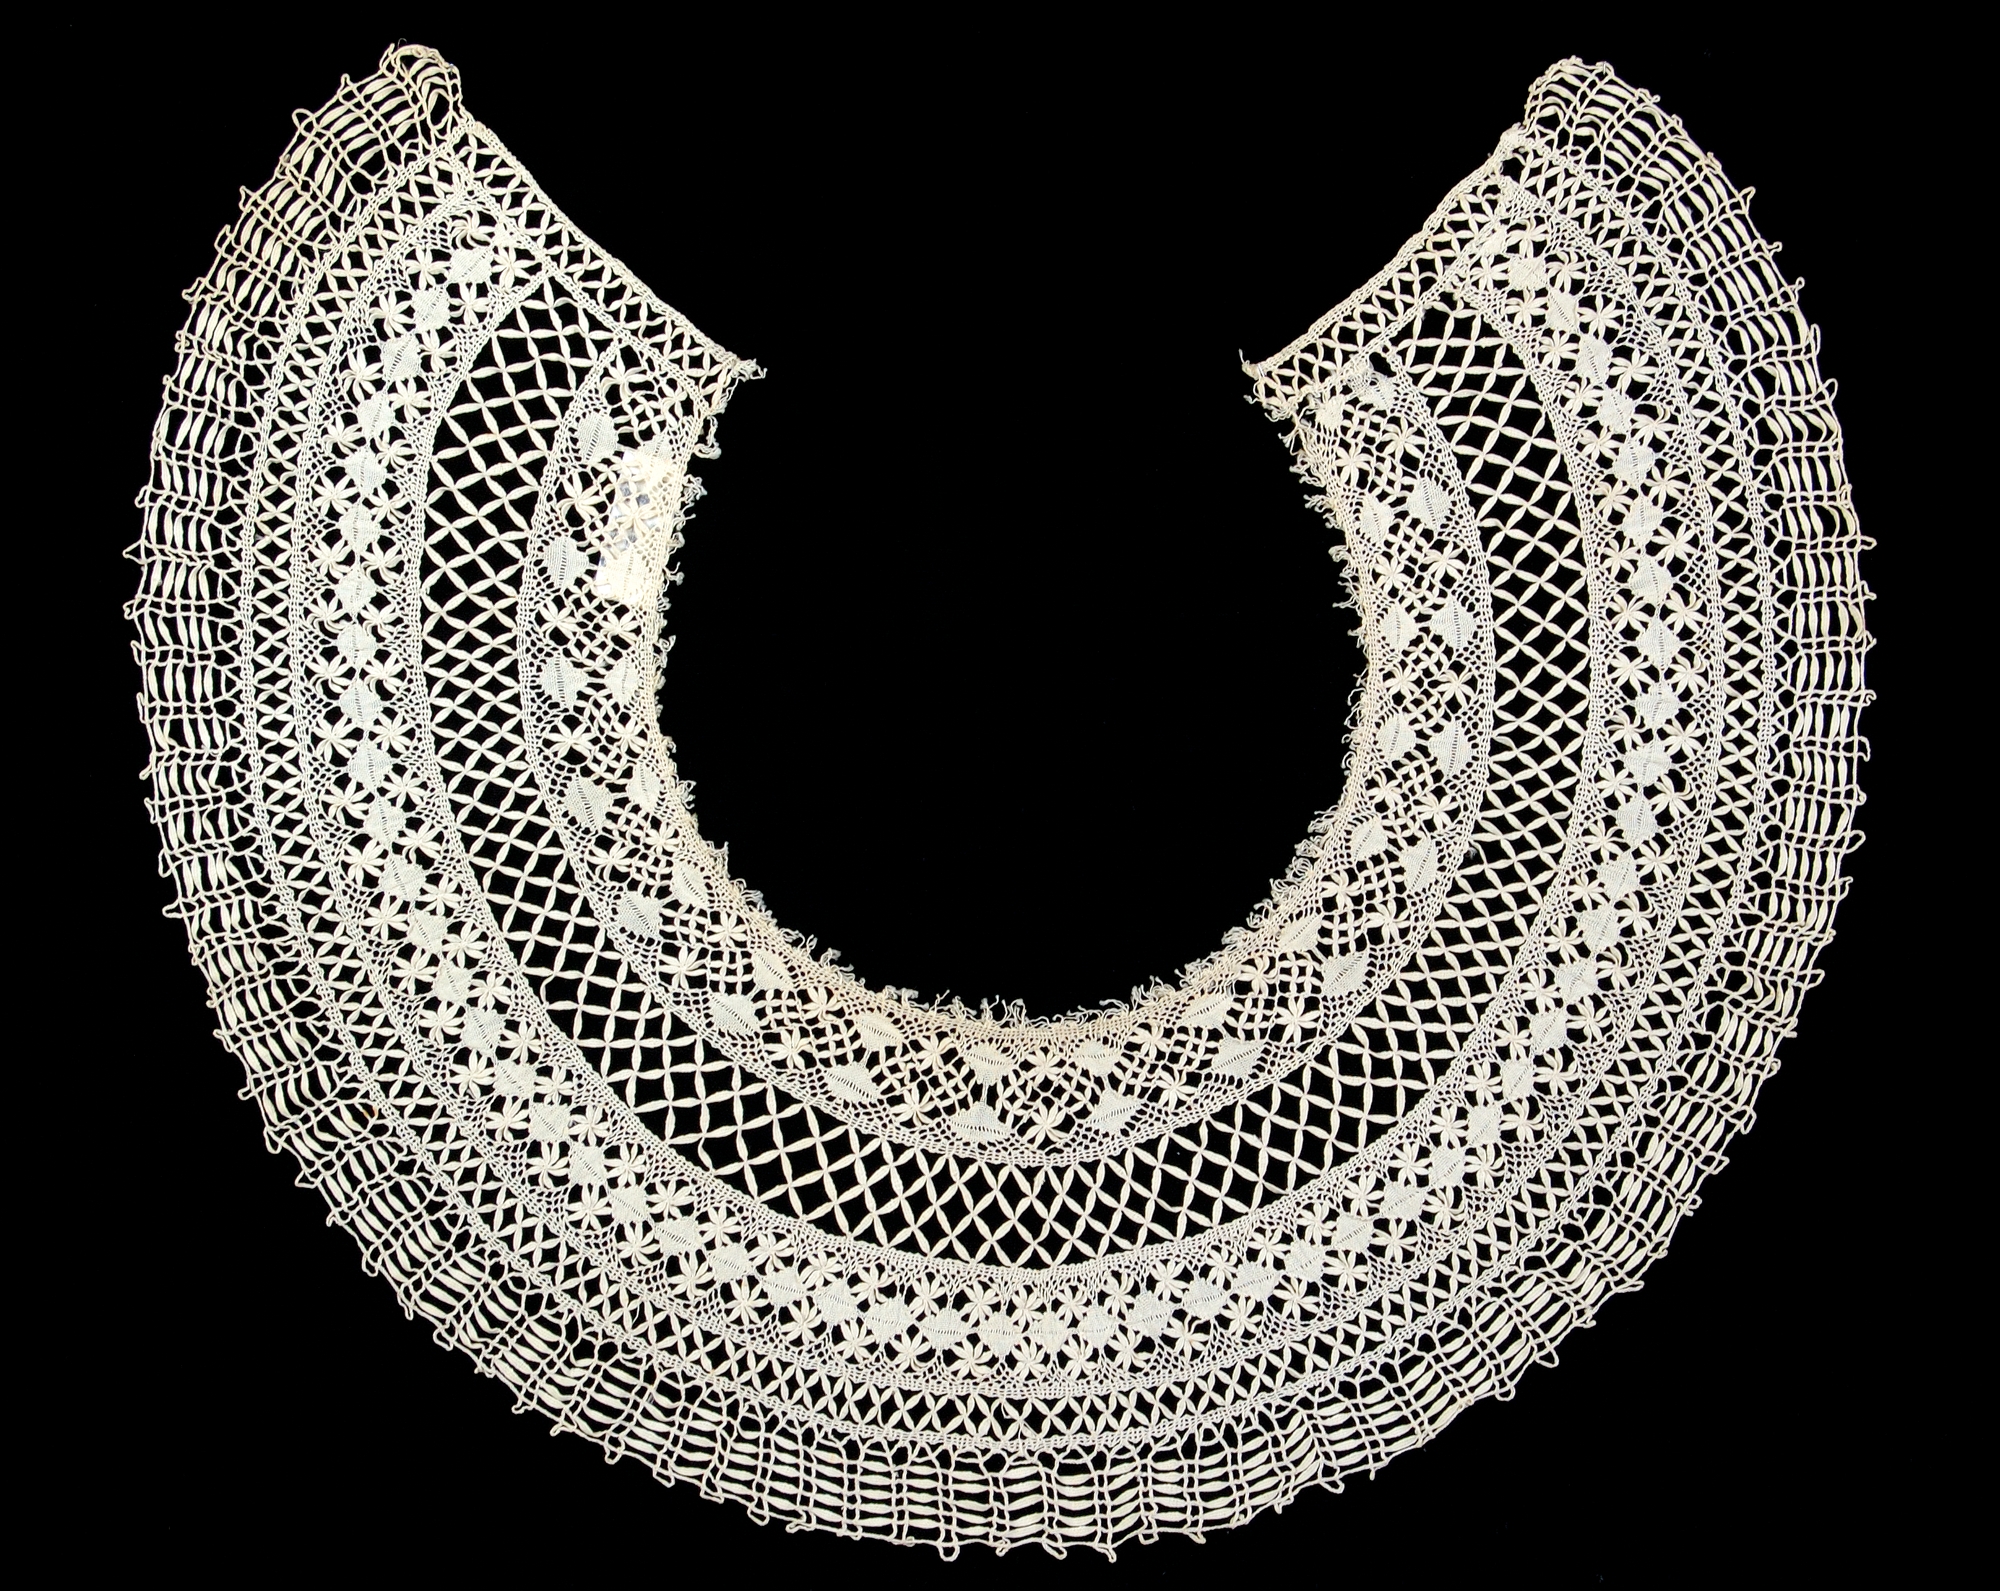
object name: collar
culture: american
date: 1890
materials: linen